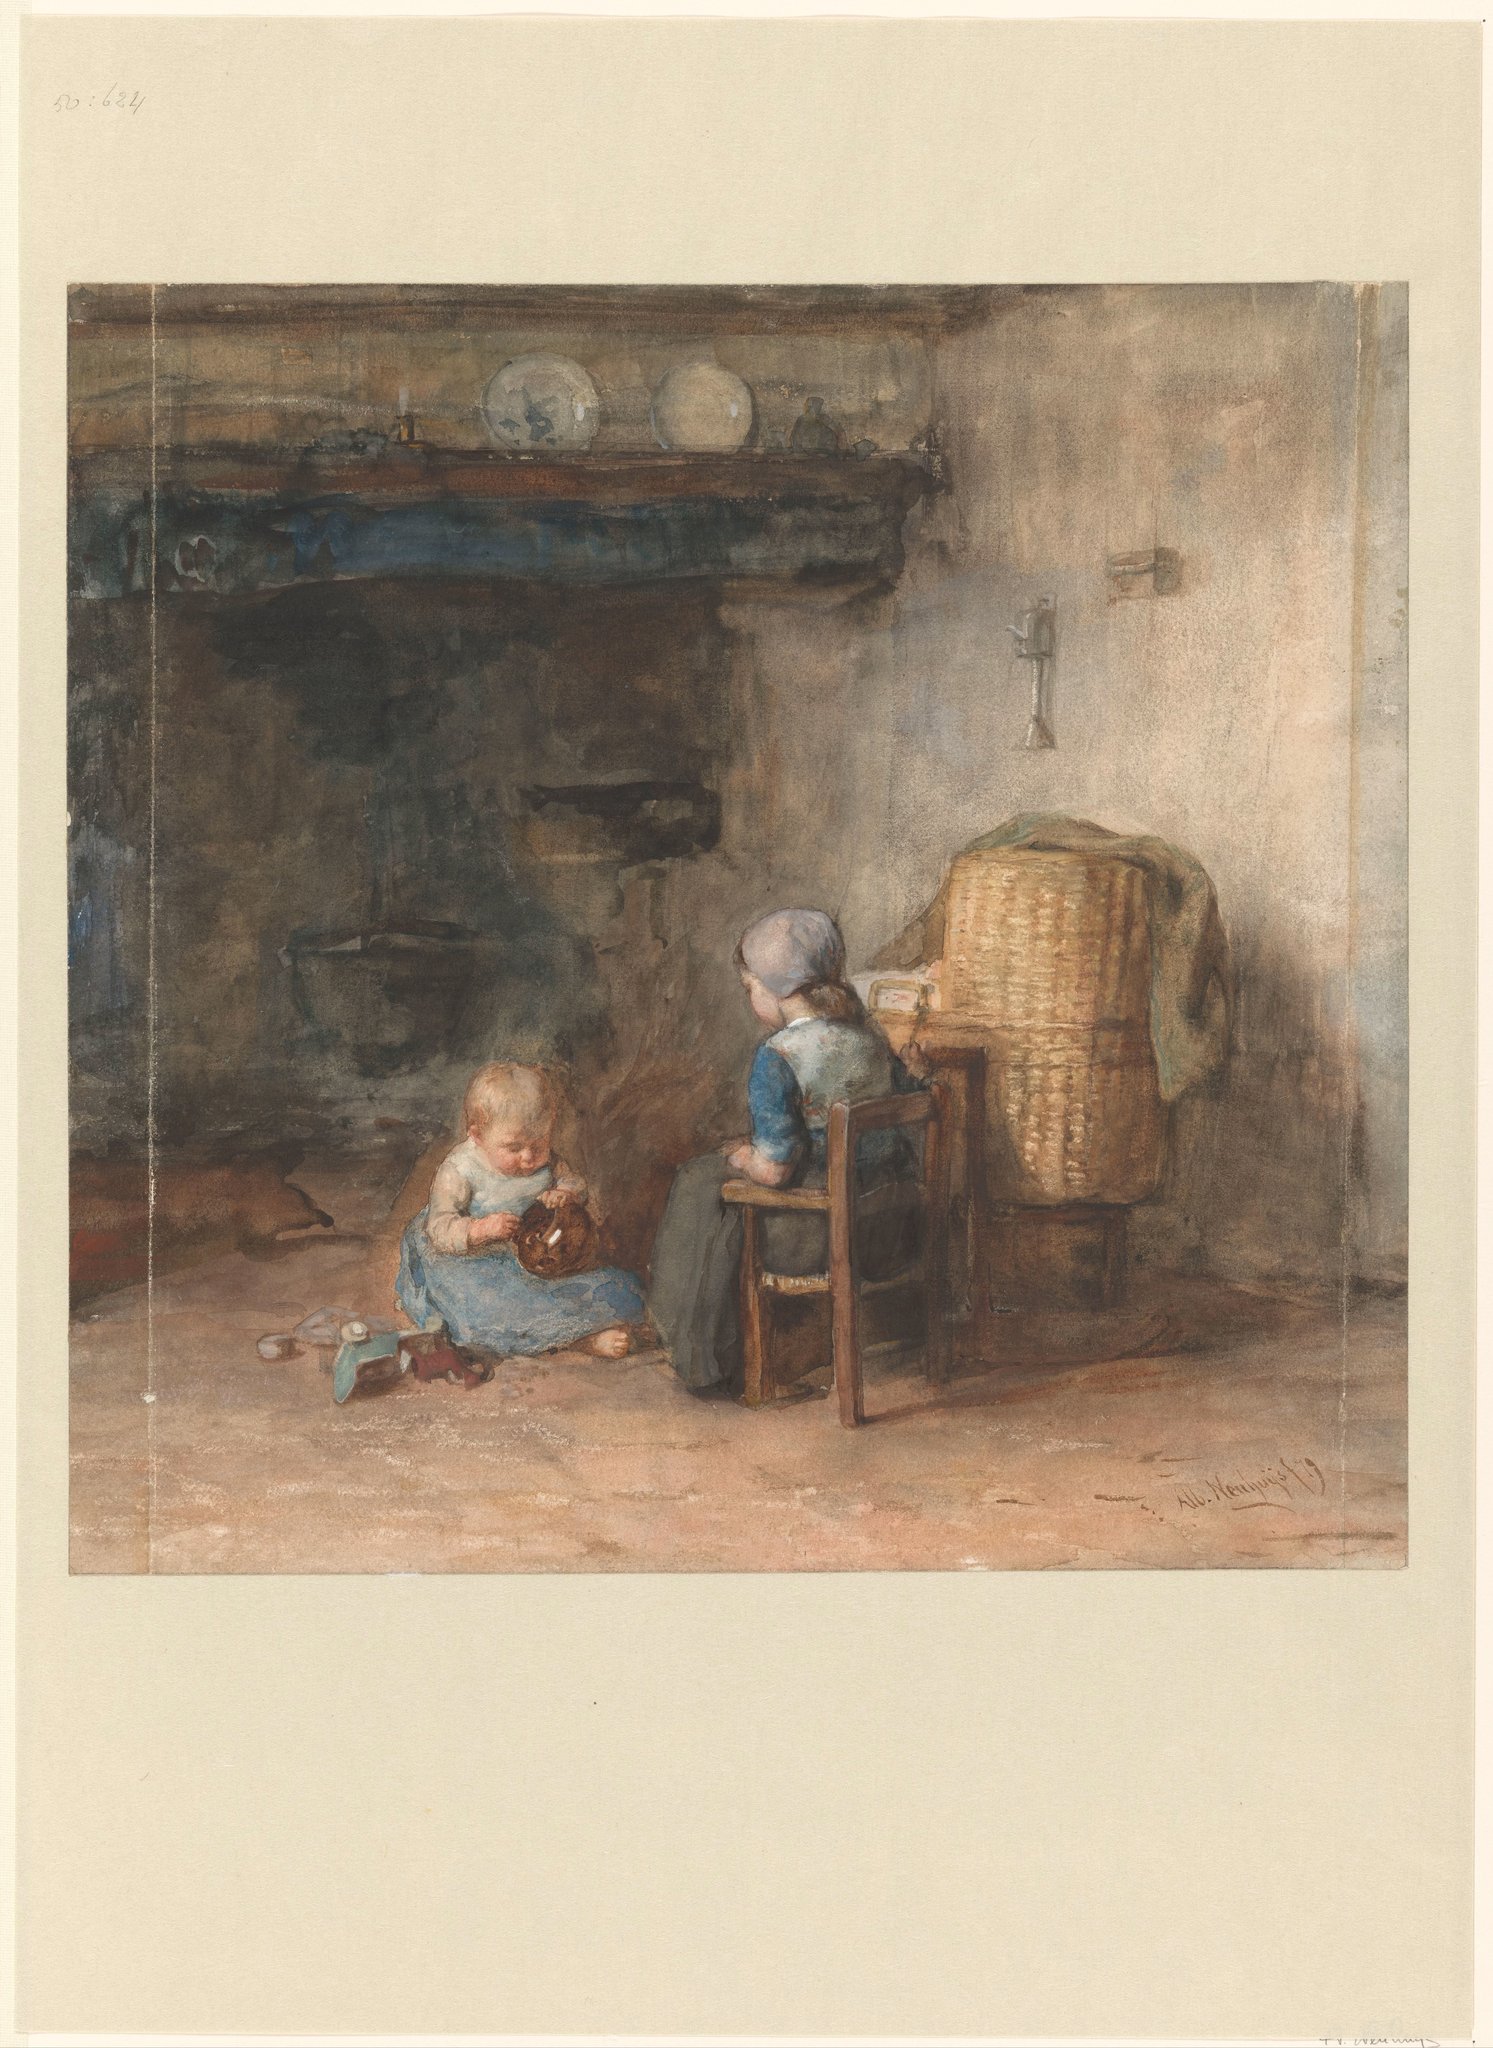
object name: drawing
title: Twee kinderen in een boereninterieur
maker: albert neuhuys (1844-1914)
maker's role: draughtsman, painter, print maker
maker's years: 1844-1914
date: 1879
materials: paper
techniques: brush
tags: farmers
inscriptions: date